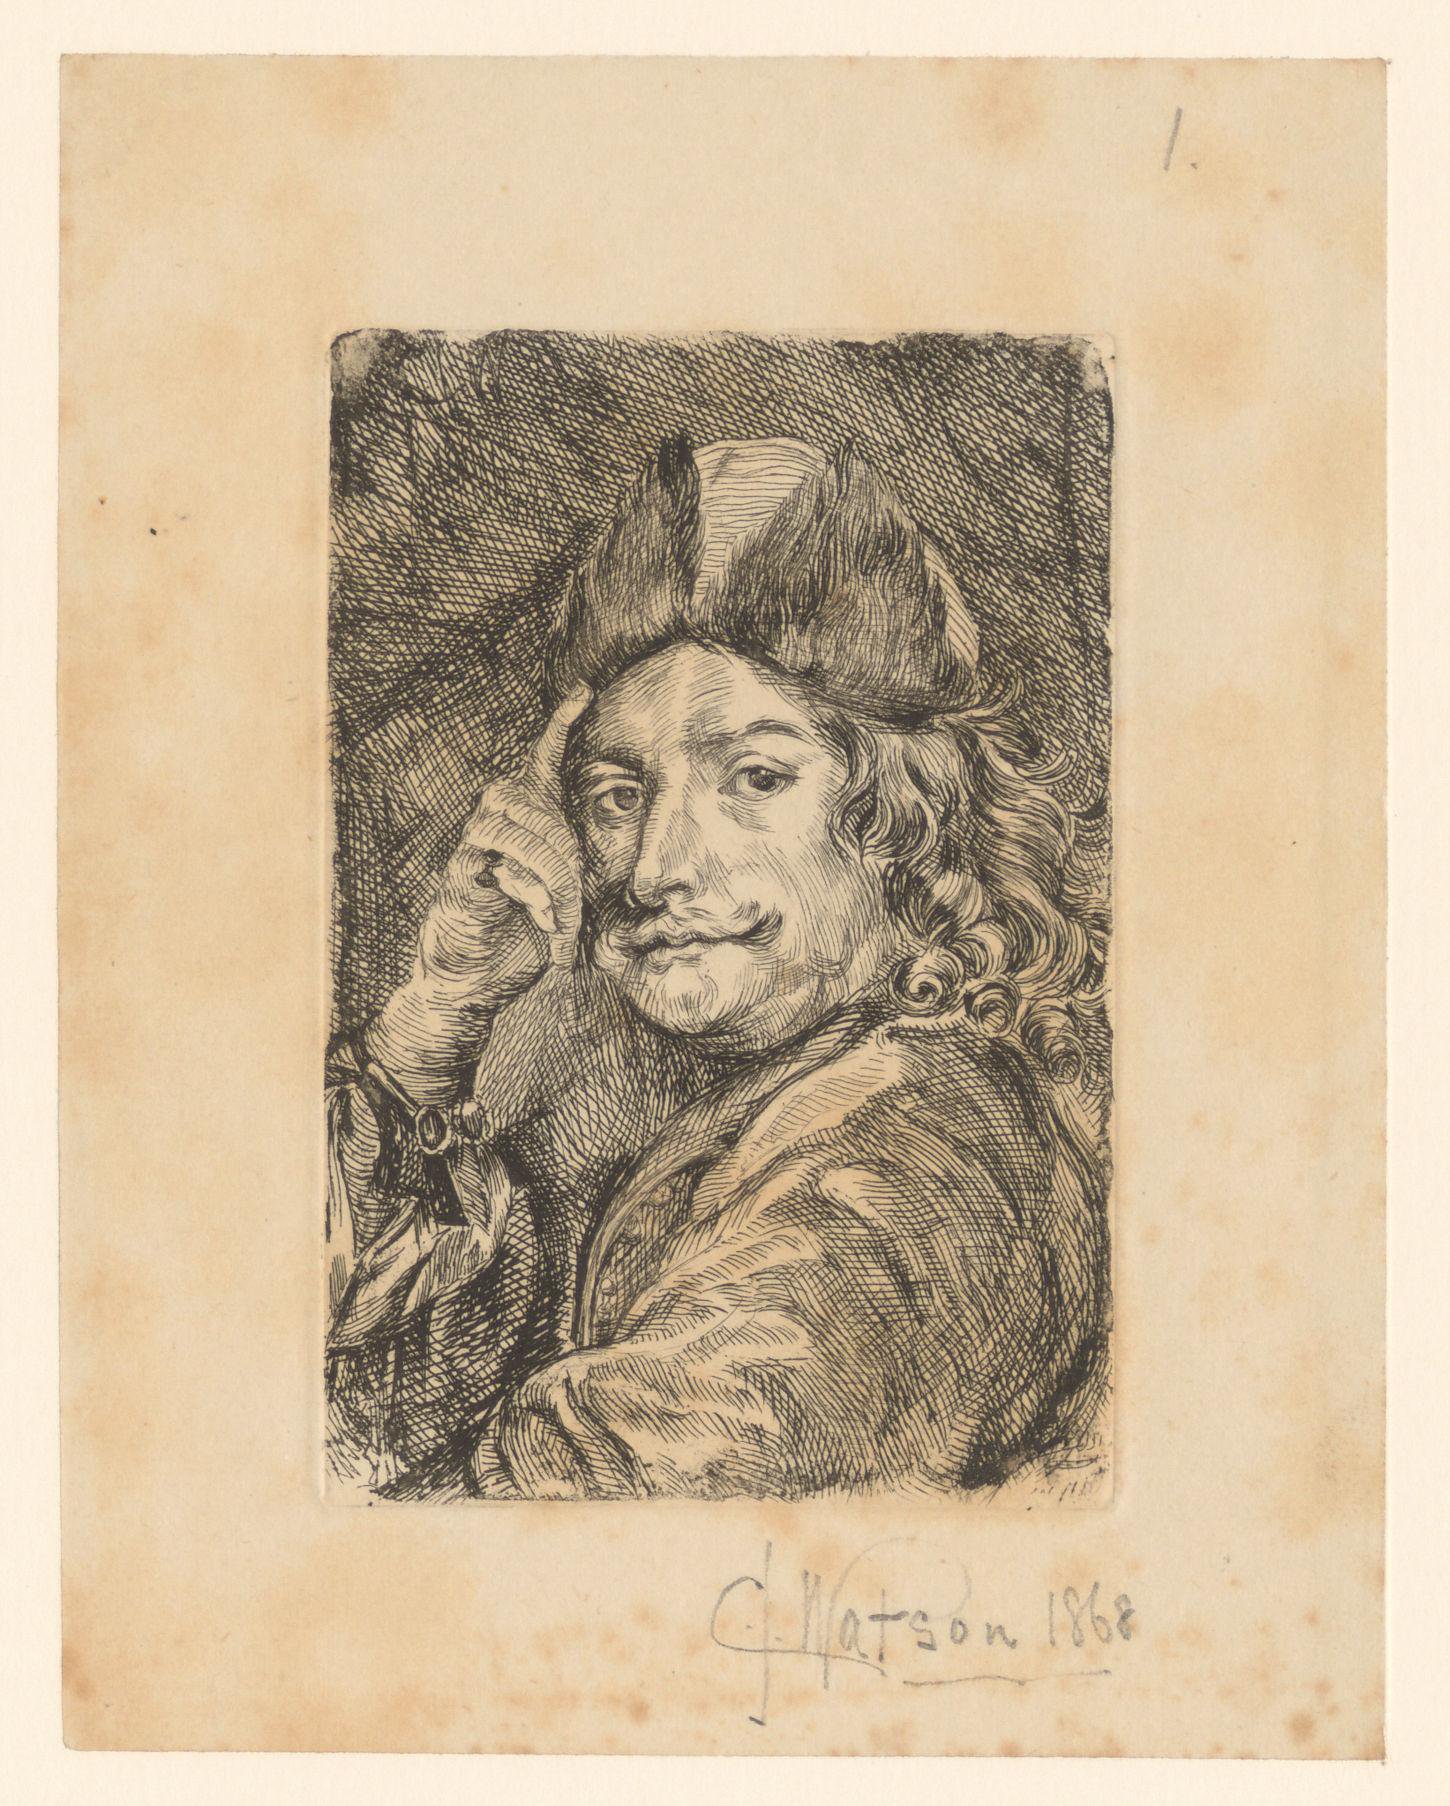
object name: print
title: Portret van Thomas Killigrew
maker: charles john watson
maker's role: print maker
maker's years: 1846-1927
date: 1868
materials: paper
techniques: etching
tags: london, court jester, court fool, historical persons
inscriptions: collector's mark: Lugt 2228